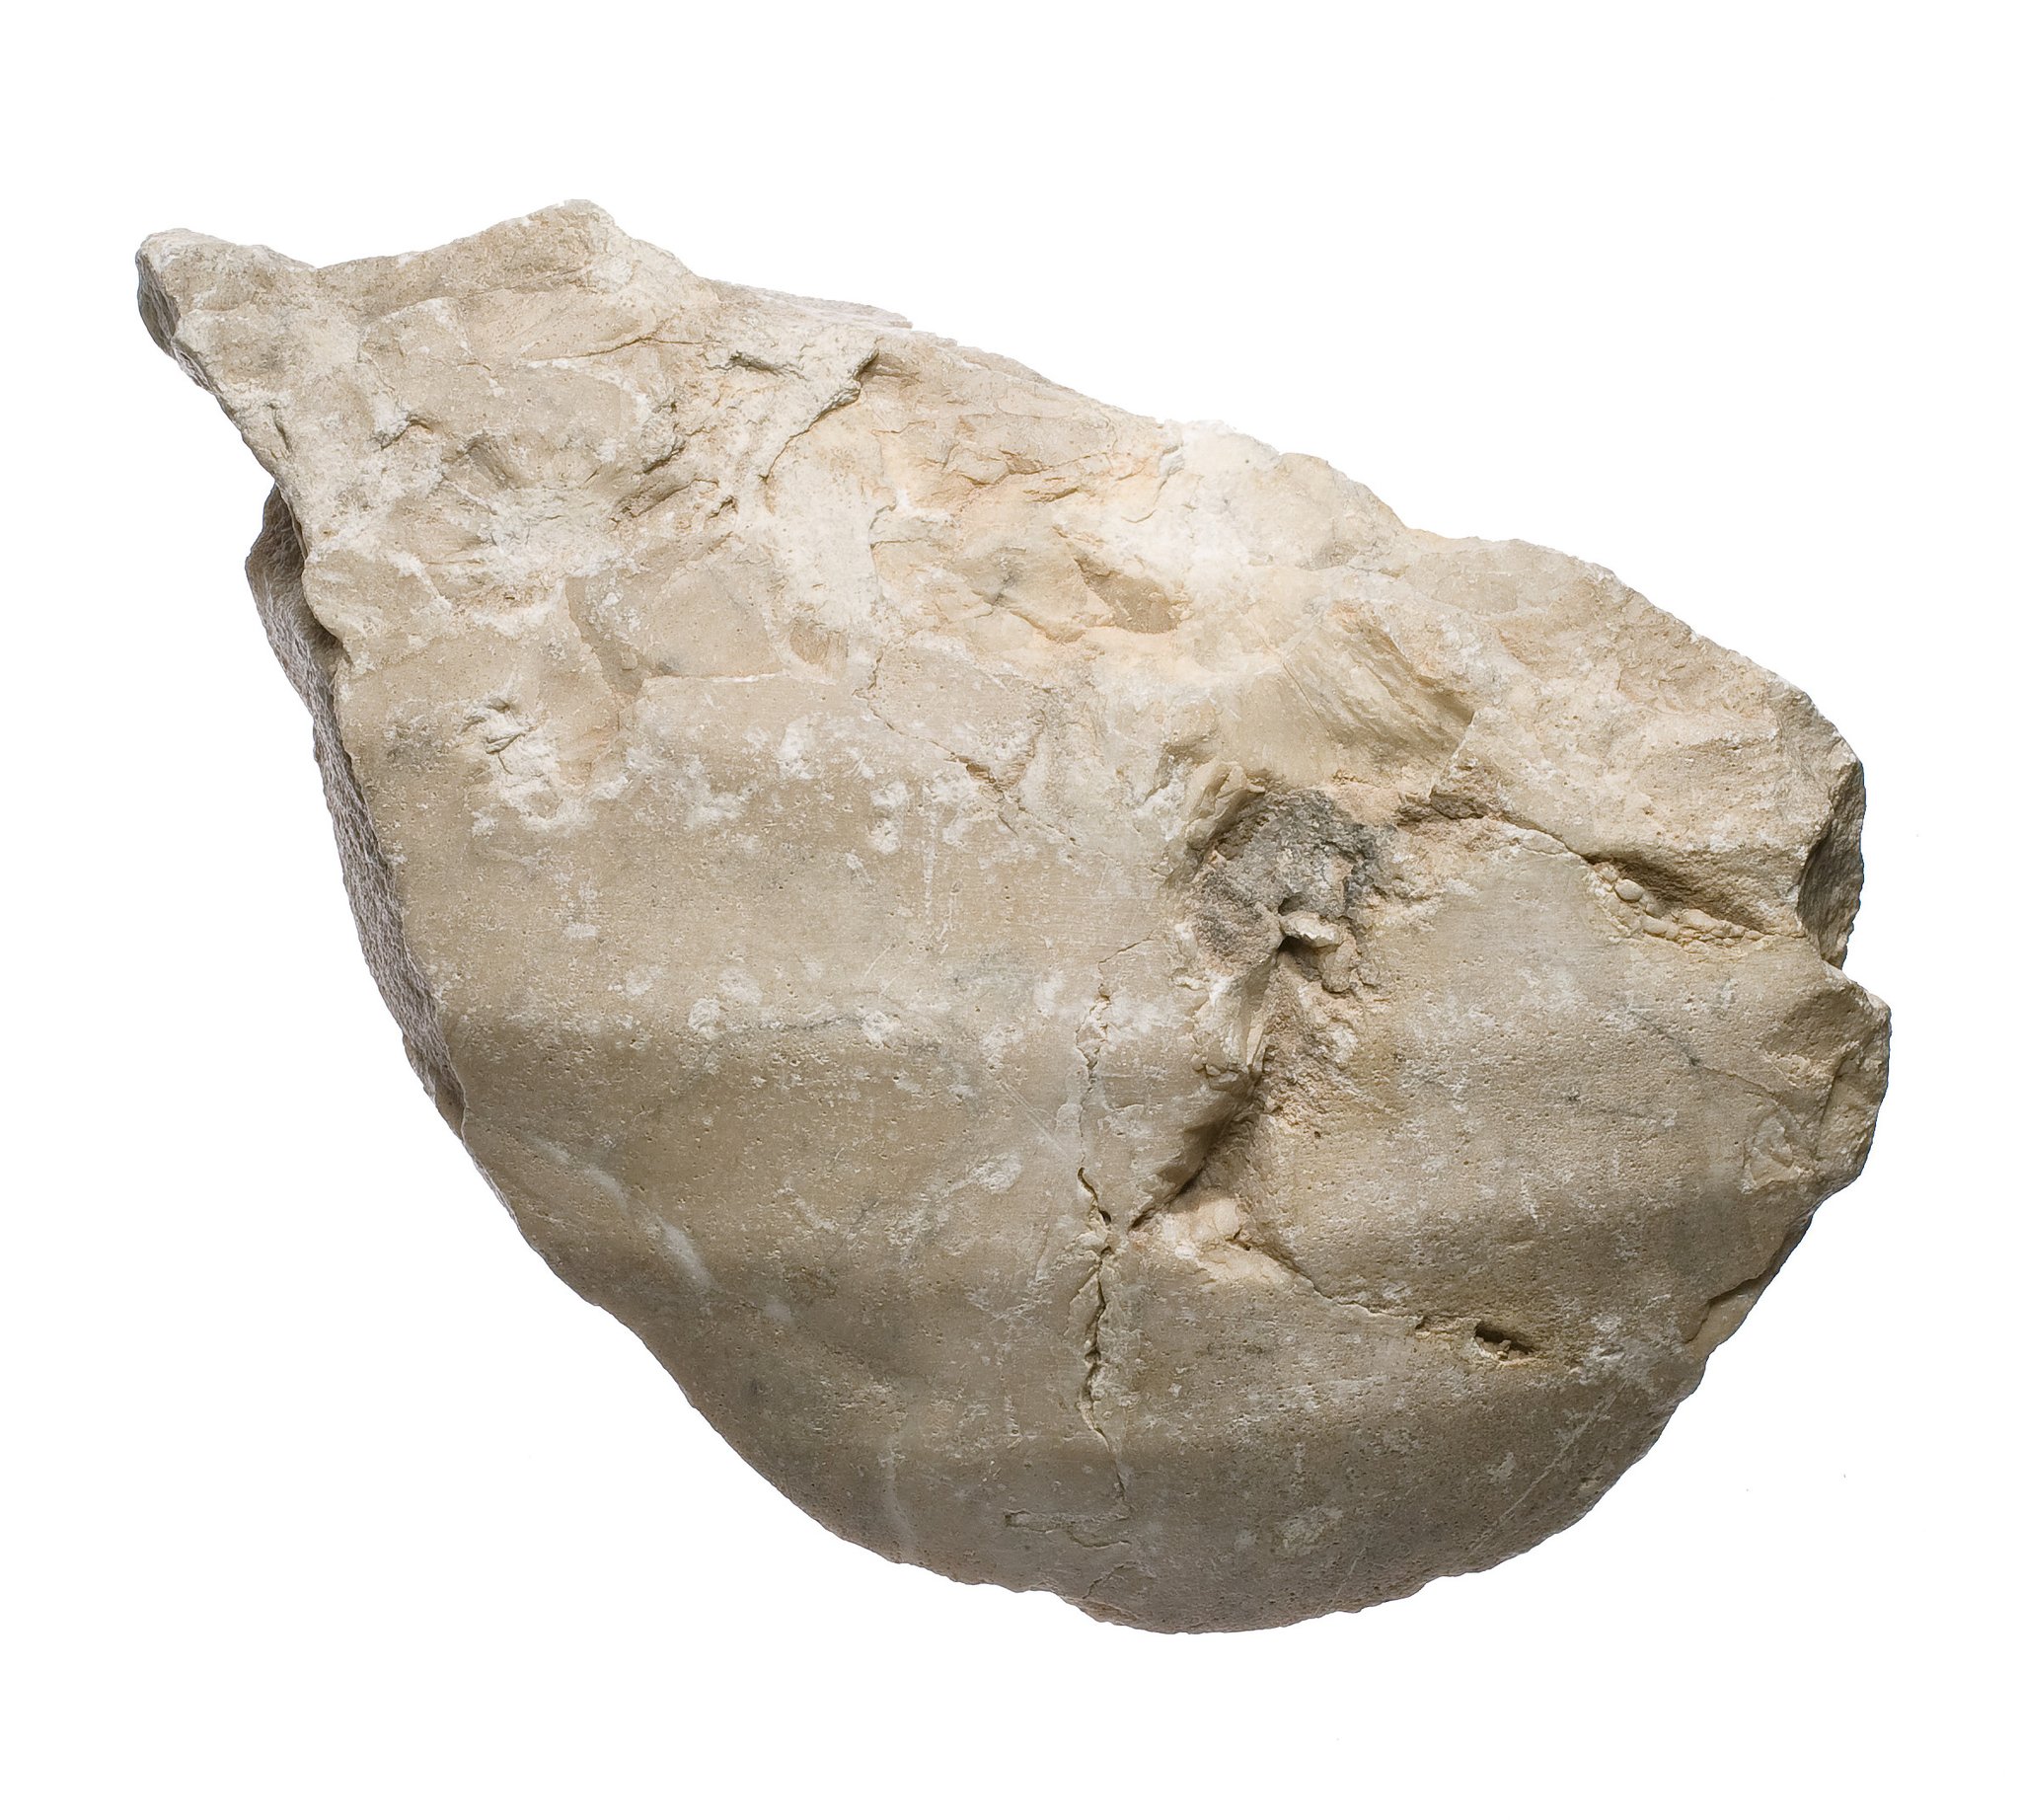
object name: body with garment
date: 1353-1336 BCE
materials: limestone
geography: egypt